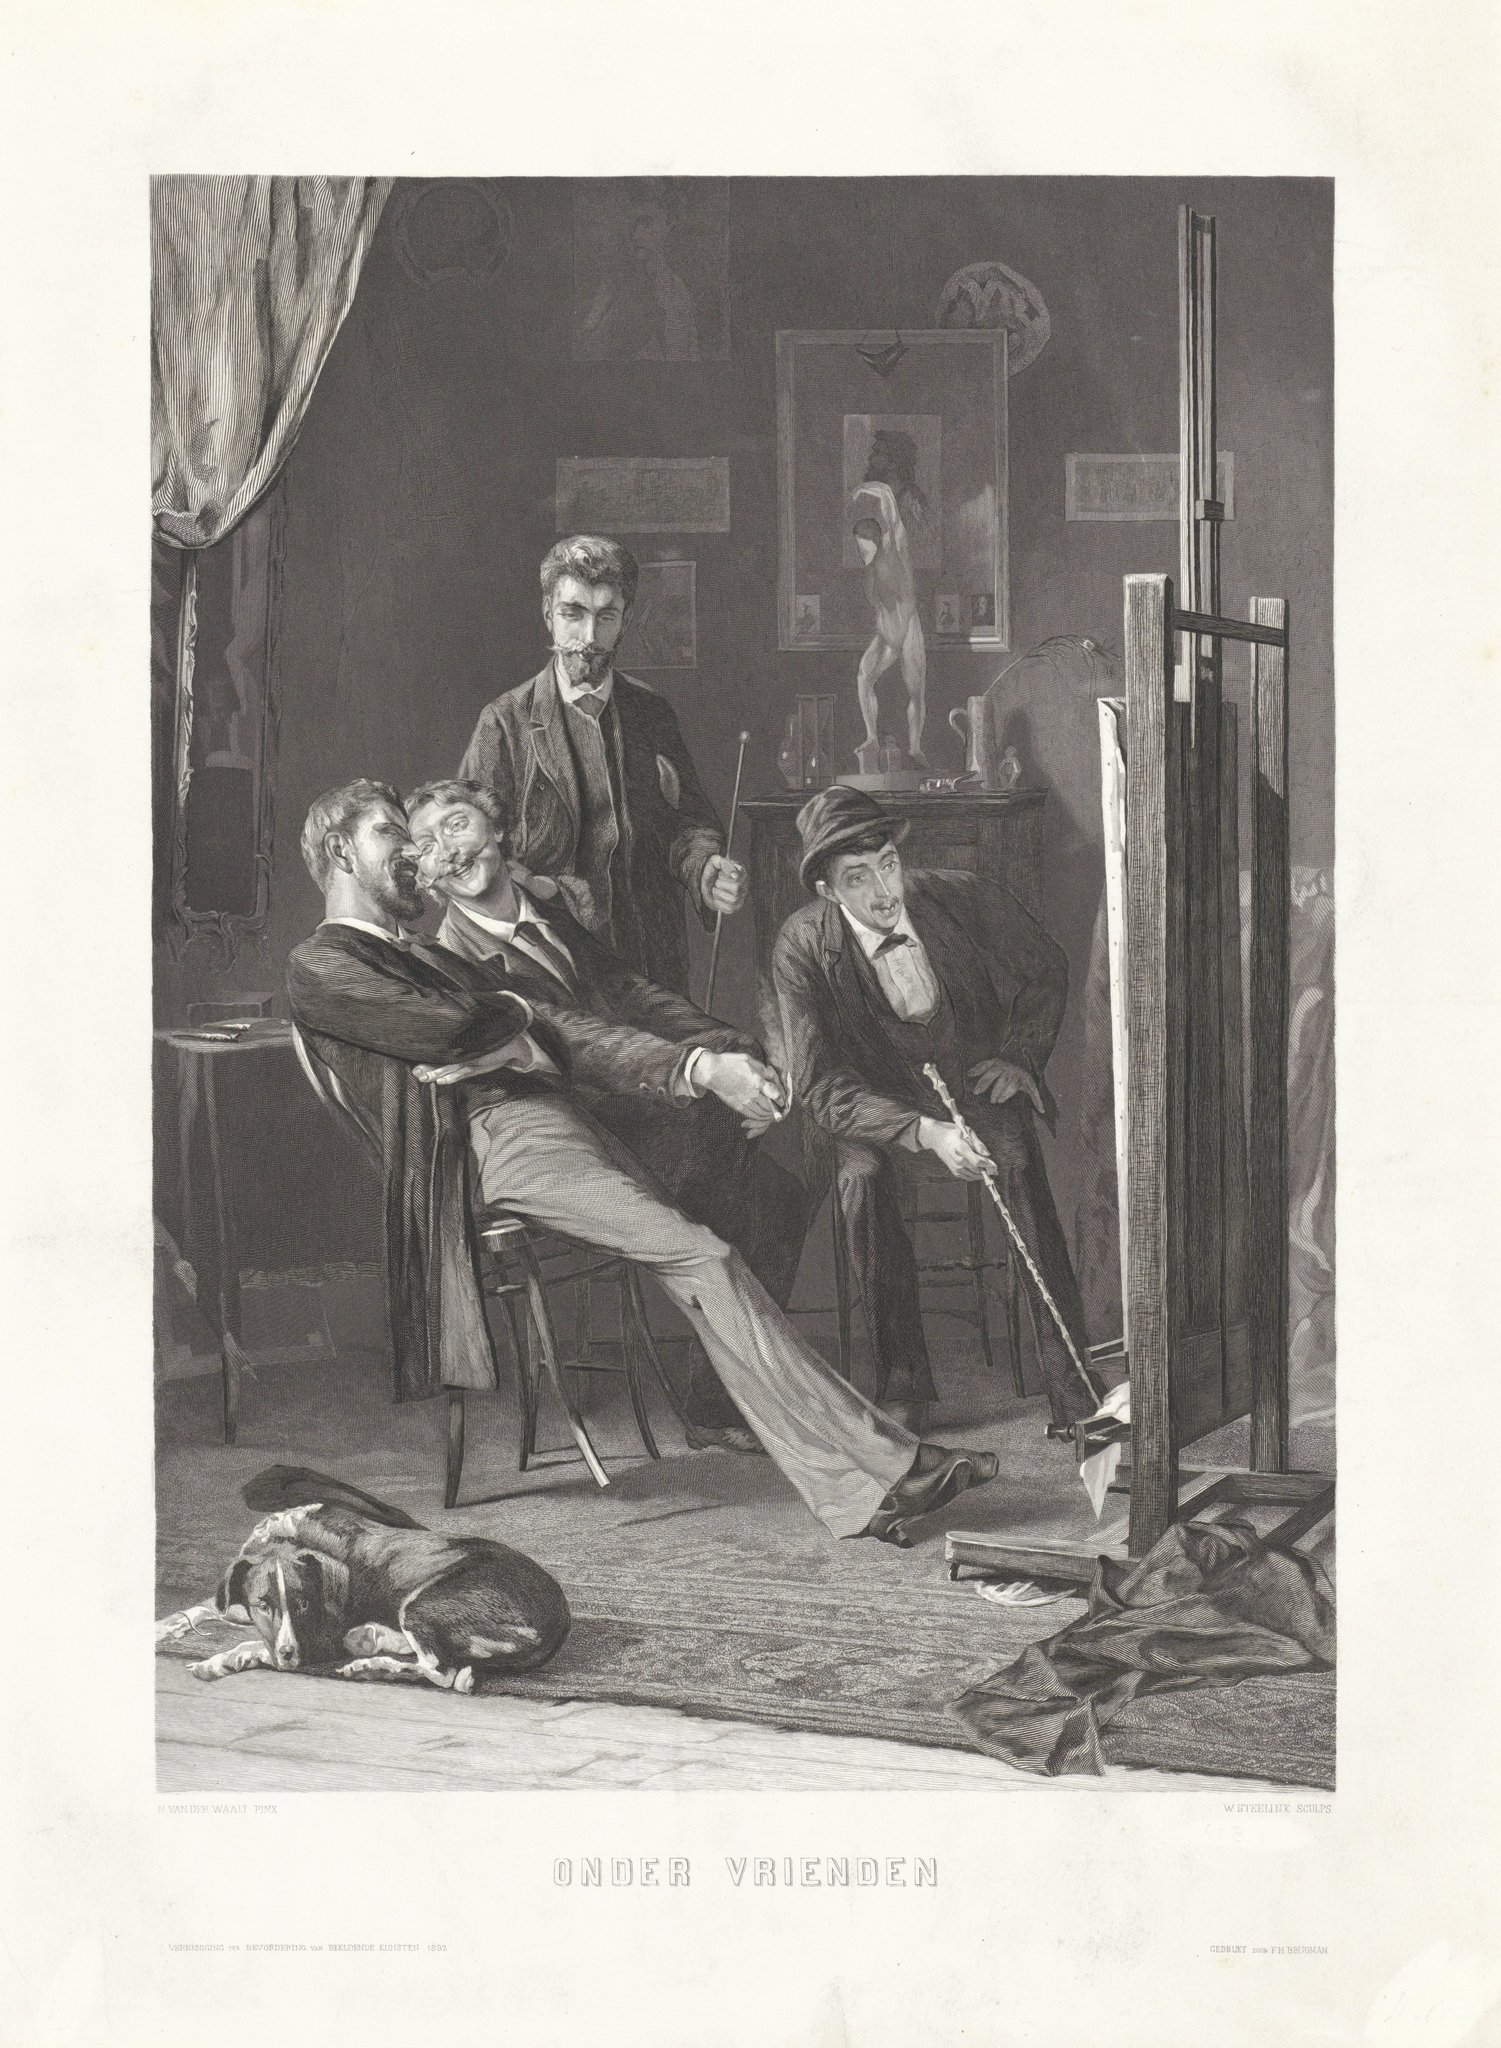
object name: print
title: Onder vrienden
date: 1882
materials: paper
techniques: engraving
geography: amsterdam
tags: painter, nicolaas van der waay, jan hillebrand wijsmuller, amsterdam, print maker, draughtsman, ferdinand oldewelt, ernst witkamp, criticizing and discussing art, art criticism, workshop, studio ~ painter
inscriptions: collector's mark: Lugt 2228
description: Vier leden van het gezelschap M.A.B., genoemd naar Michelangelo Buonarrotti, in een schildersatelier. Van links naar rechts: Jan Hillebrand Wijsmuller, Nicolaas van der Waay, Ferdinand Oldewelt en Ernst Witkamp. Zij bekijken het schilderij dat op de ezel staat. Op de voorgrond een liggende hond.